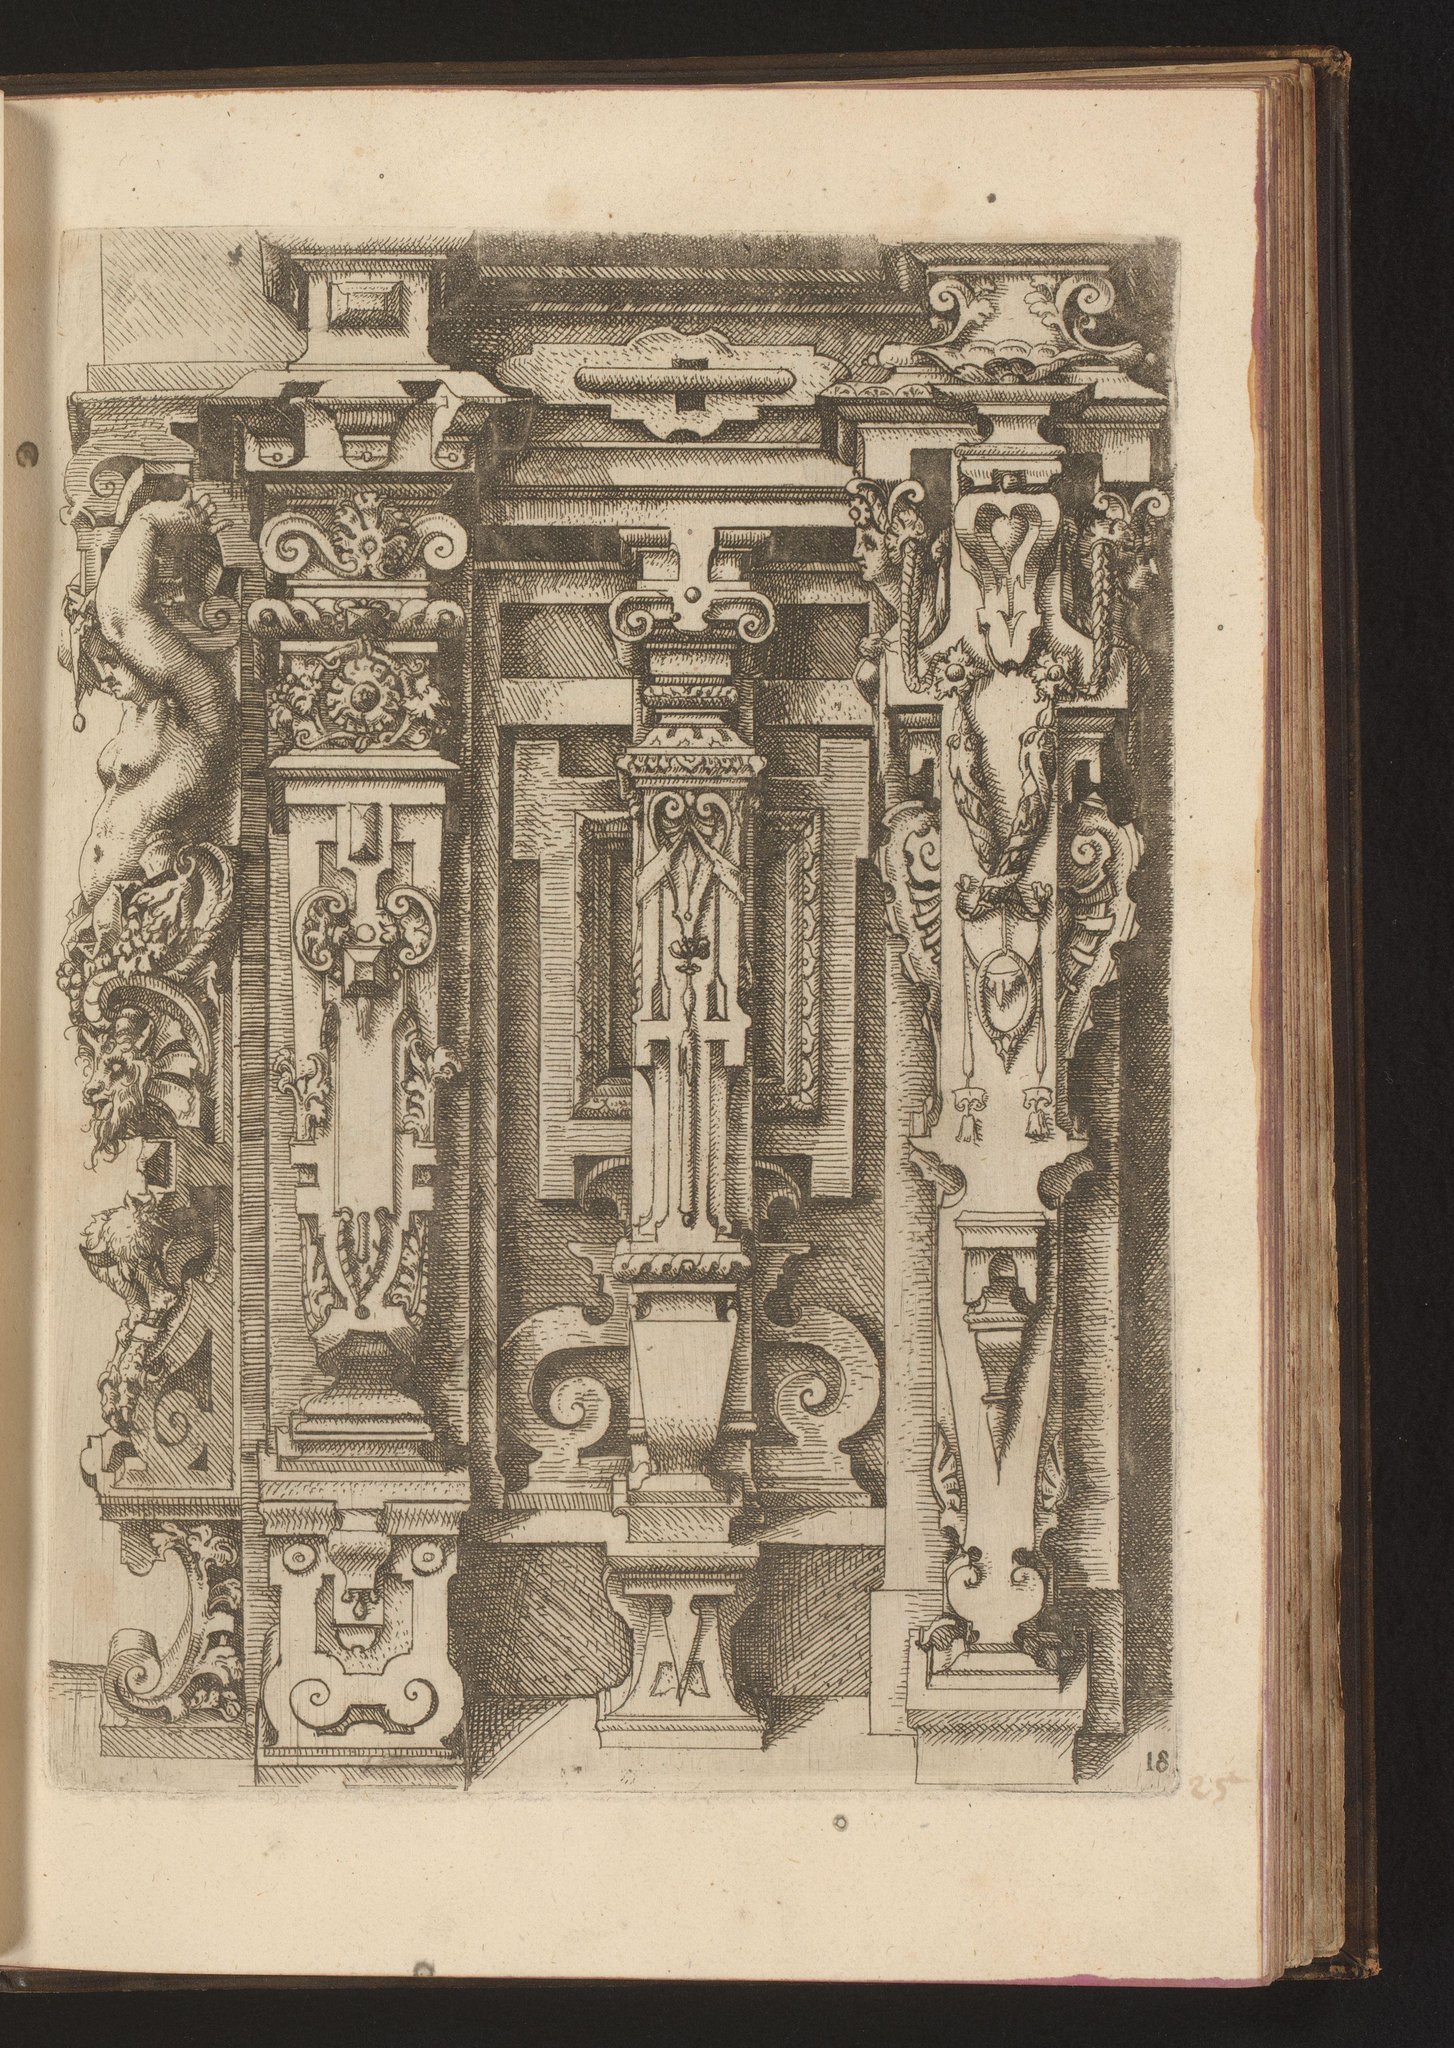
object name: book illustration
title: Architectura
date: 1593-1595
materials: paper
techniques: etching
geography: straatsburg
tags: ram's head ~ ornament, column, pillar ~ architecture, caryatids ~ architecture, other architectural details, ionic order ~ architecture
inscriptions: collector's mark: Lugt 2760, collector's mark: Lugt 2228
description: Prent gebruikt in: Dietterlin, Wendel (I). Architectura de quinq[ue] columnarum simmetrica distributione et variis eorundem or namentis: Liber I. Straatsburg: Bernhard Jobin, 1593.